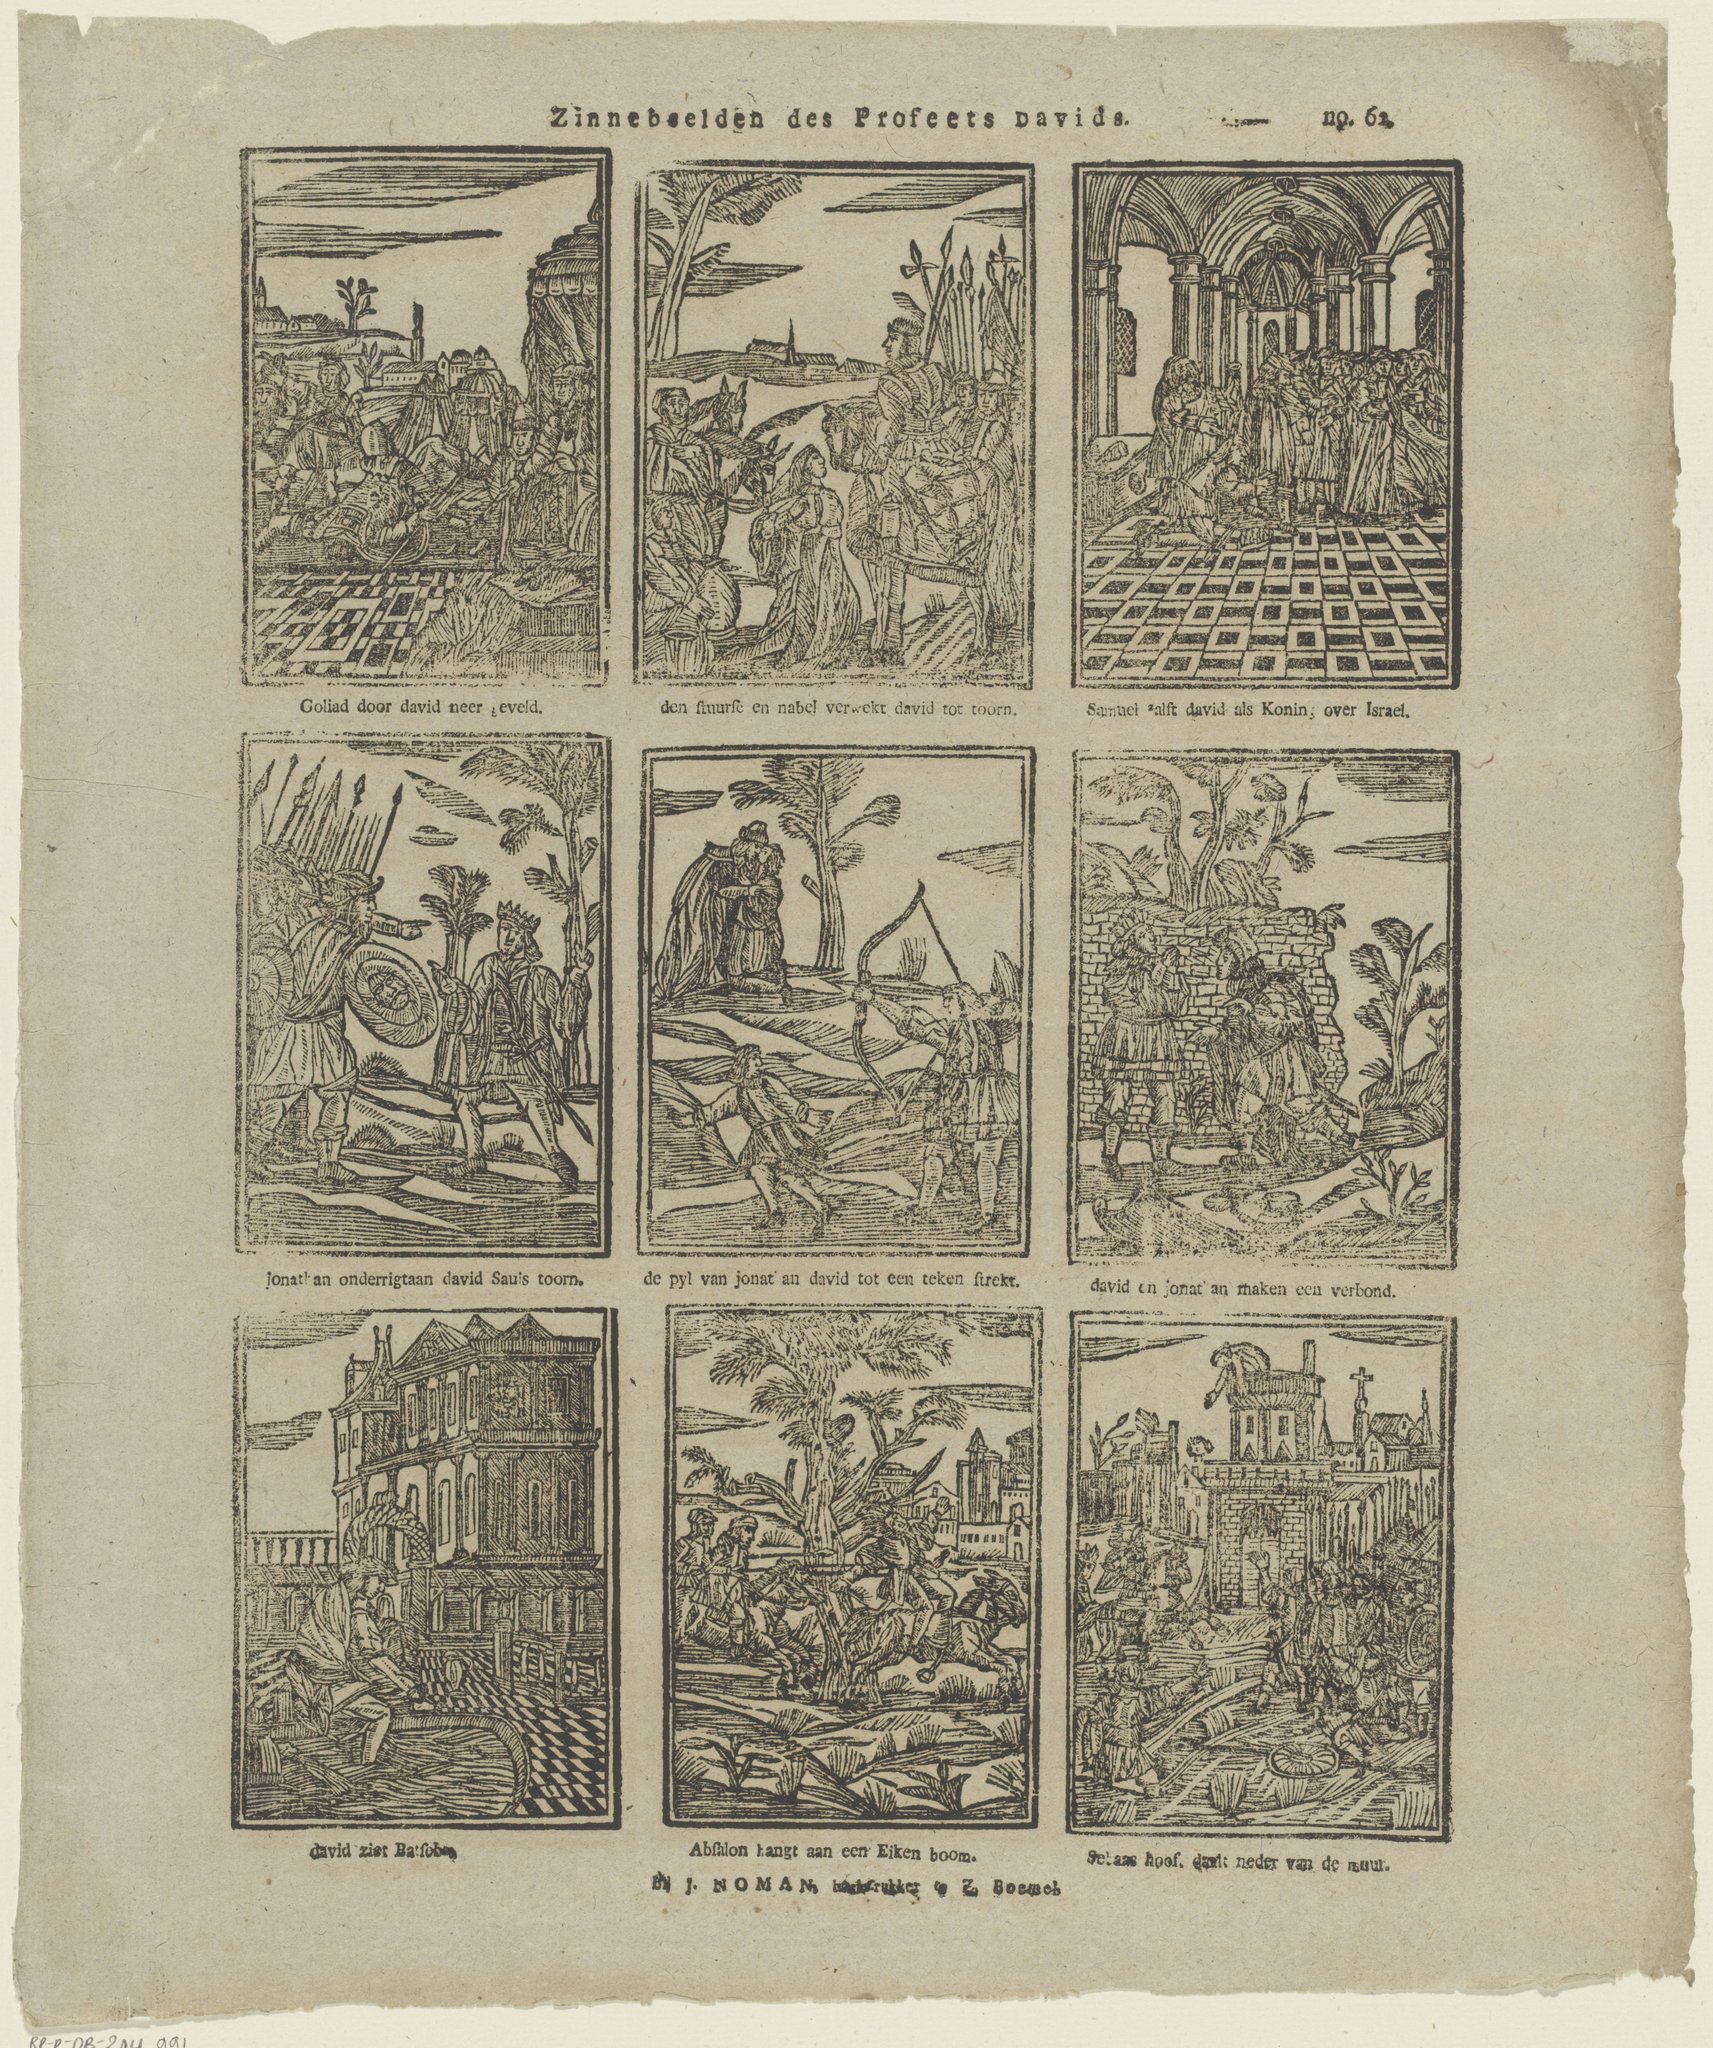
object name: popular print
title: Zinnebeelden des profeets Davids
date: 1806-1830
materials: paper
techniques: letterpress printing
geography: zaltbommel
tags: story of david, old testament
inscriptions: collector's mark: Lugt 2760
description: Blad met 9 voorstellingen uit het het leven van David en van verhalen uit het Oude Testament. Onder elke afbeelding een onderschrift. Genummerd rechtsboven: no. 62.